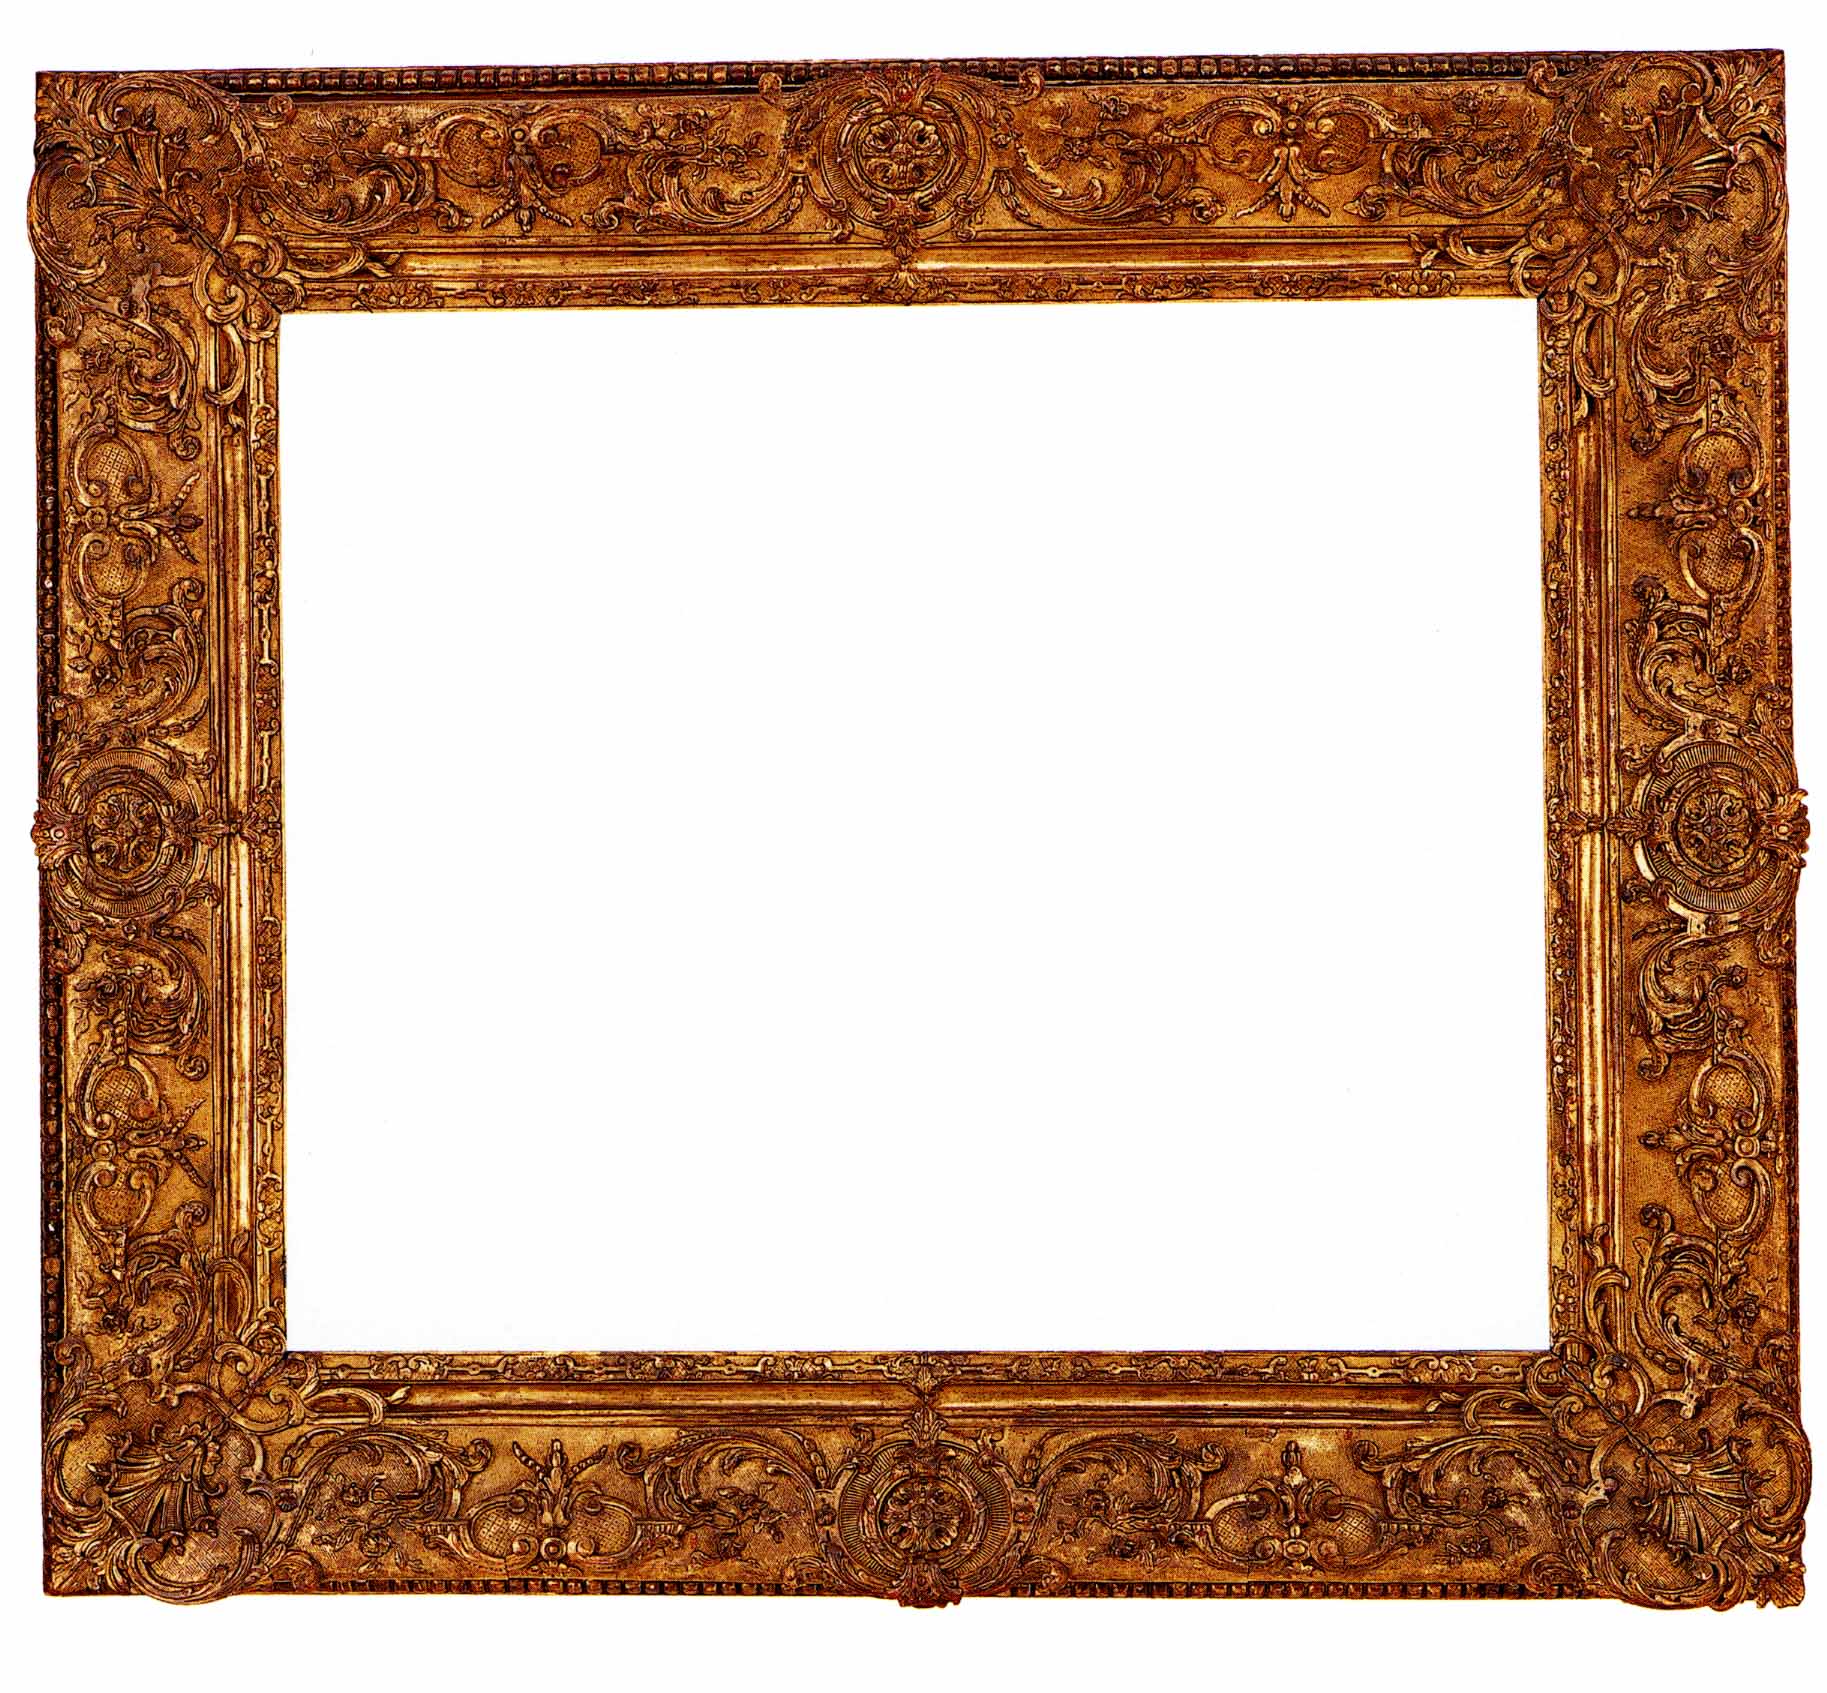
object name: frame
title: Early 18th-century style Ogee frame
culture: french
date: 1850-1865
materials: gilt, wood, patina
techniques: carving